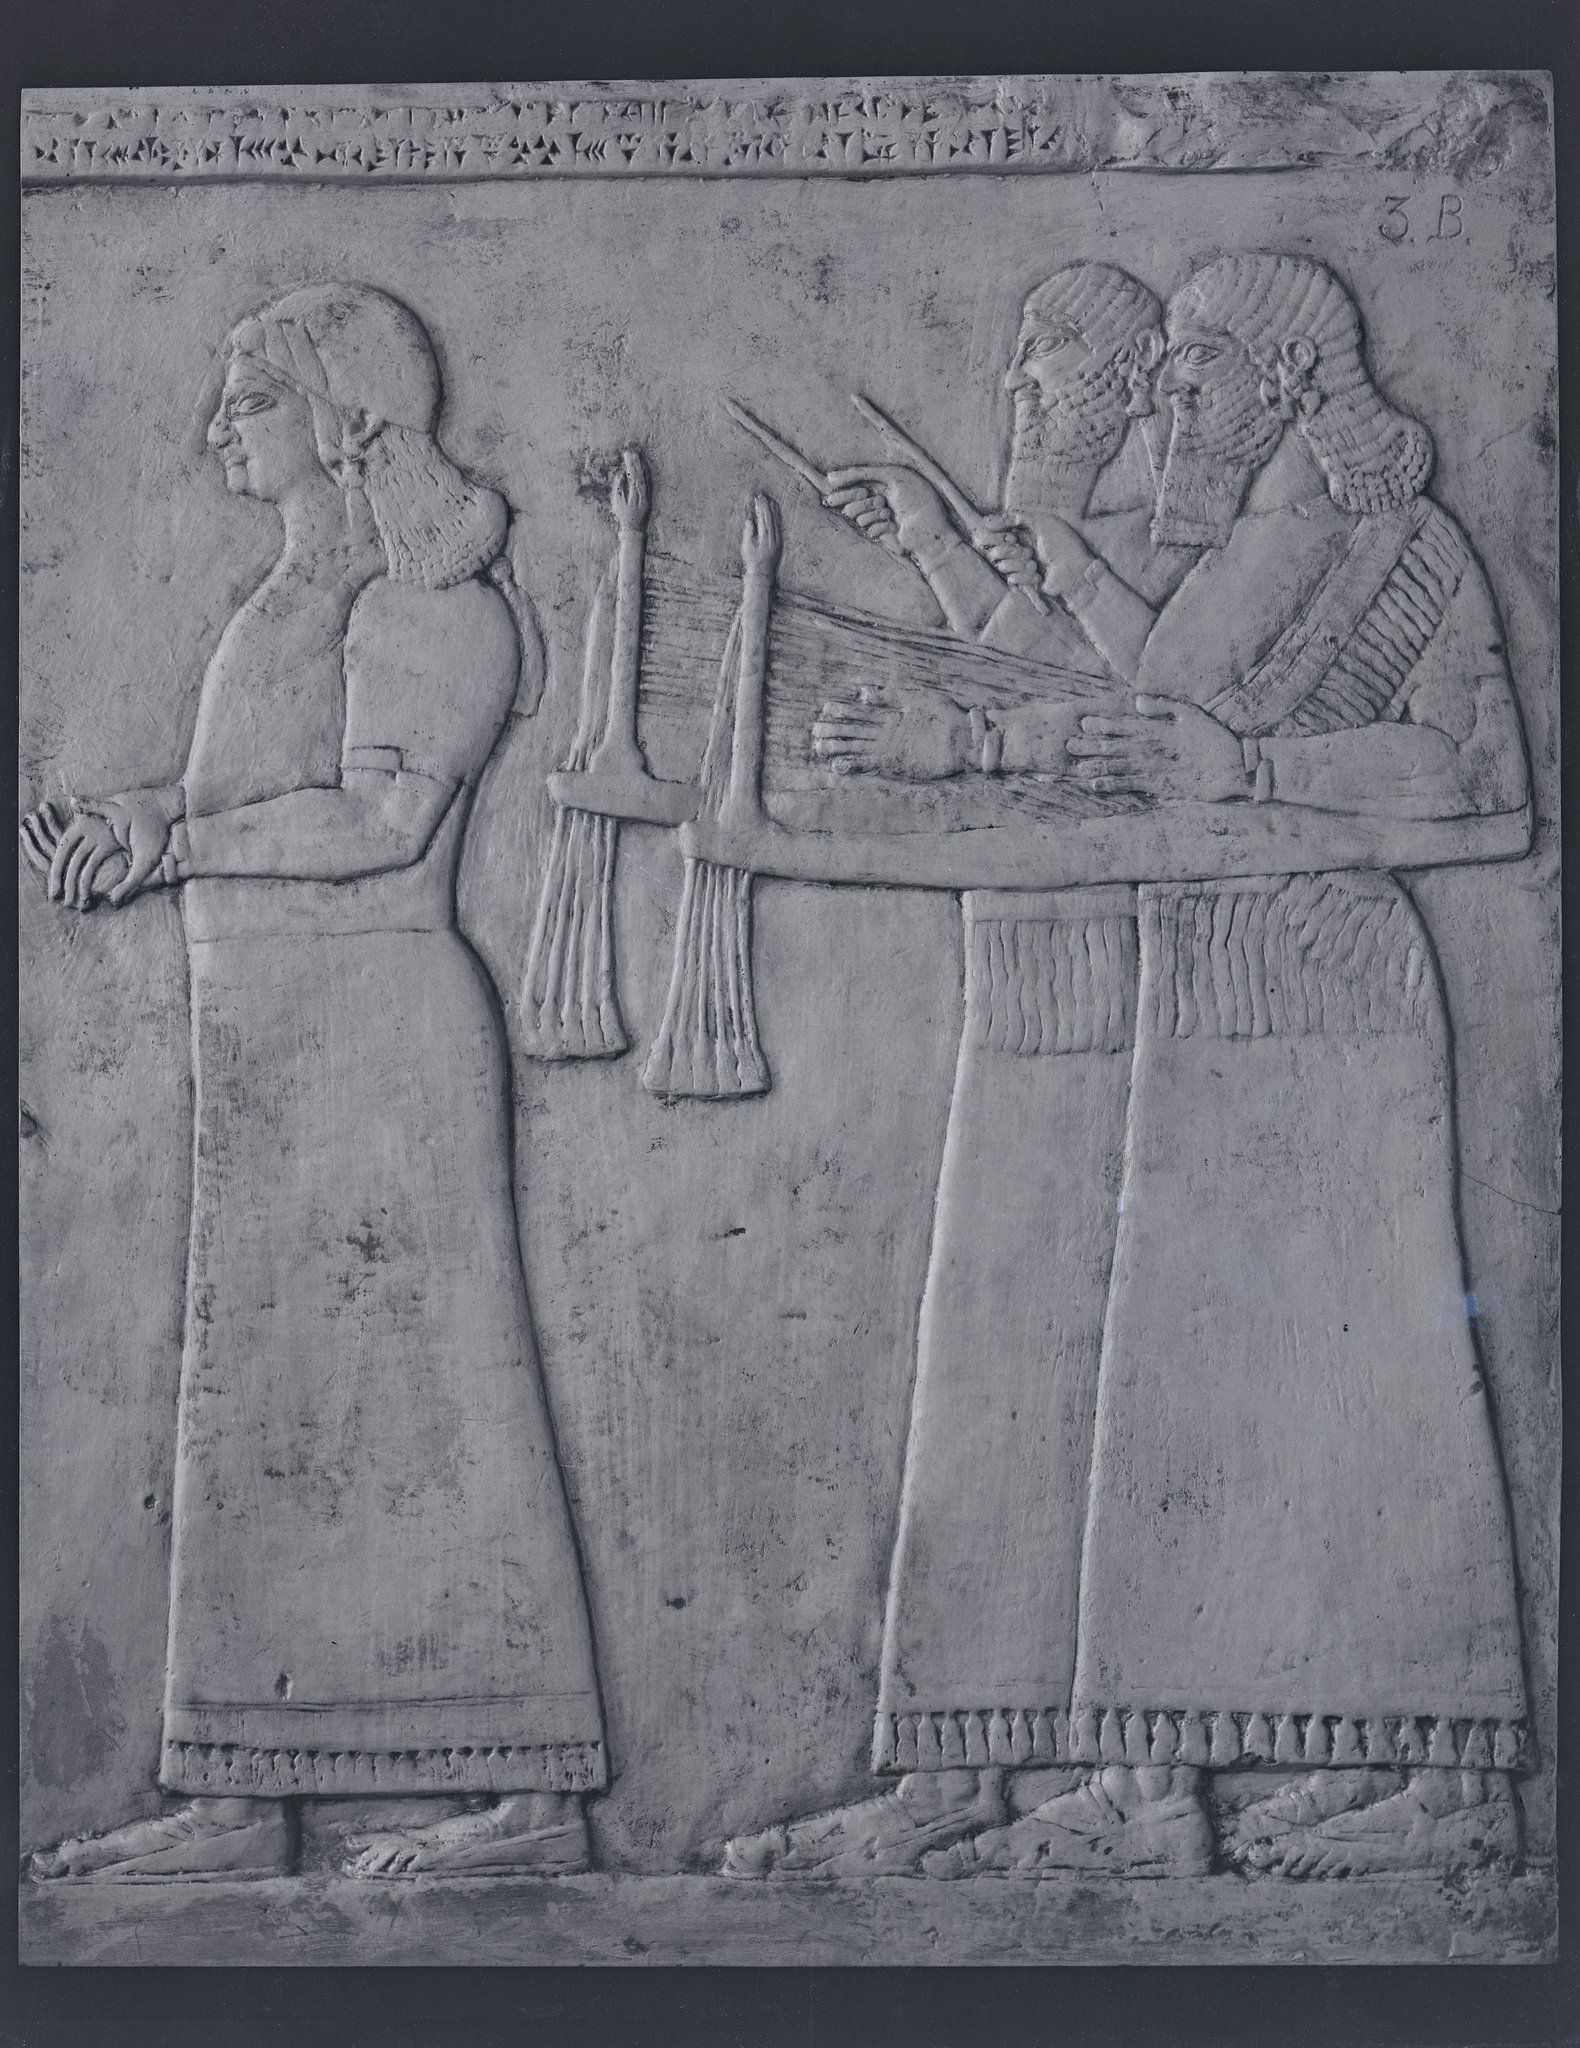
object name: cast of relief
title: Cast of relief: musicians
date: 9 BCE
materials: plaster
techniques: painting